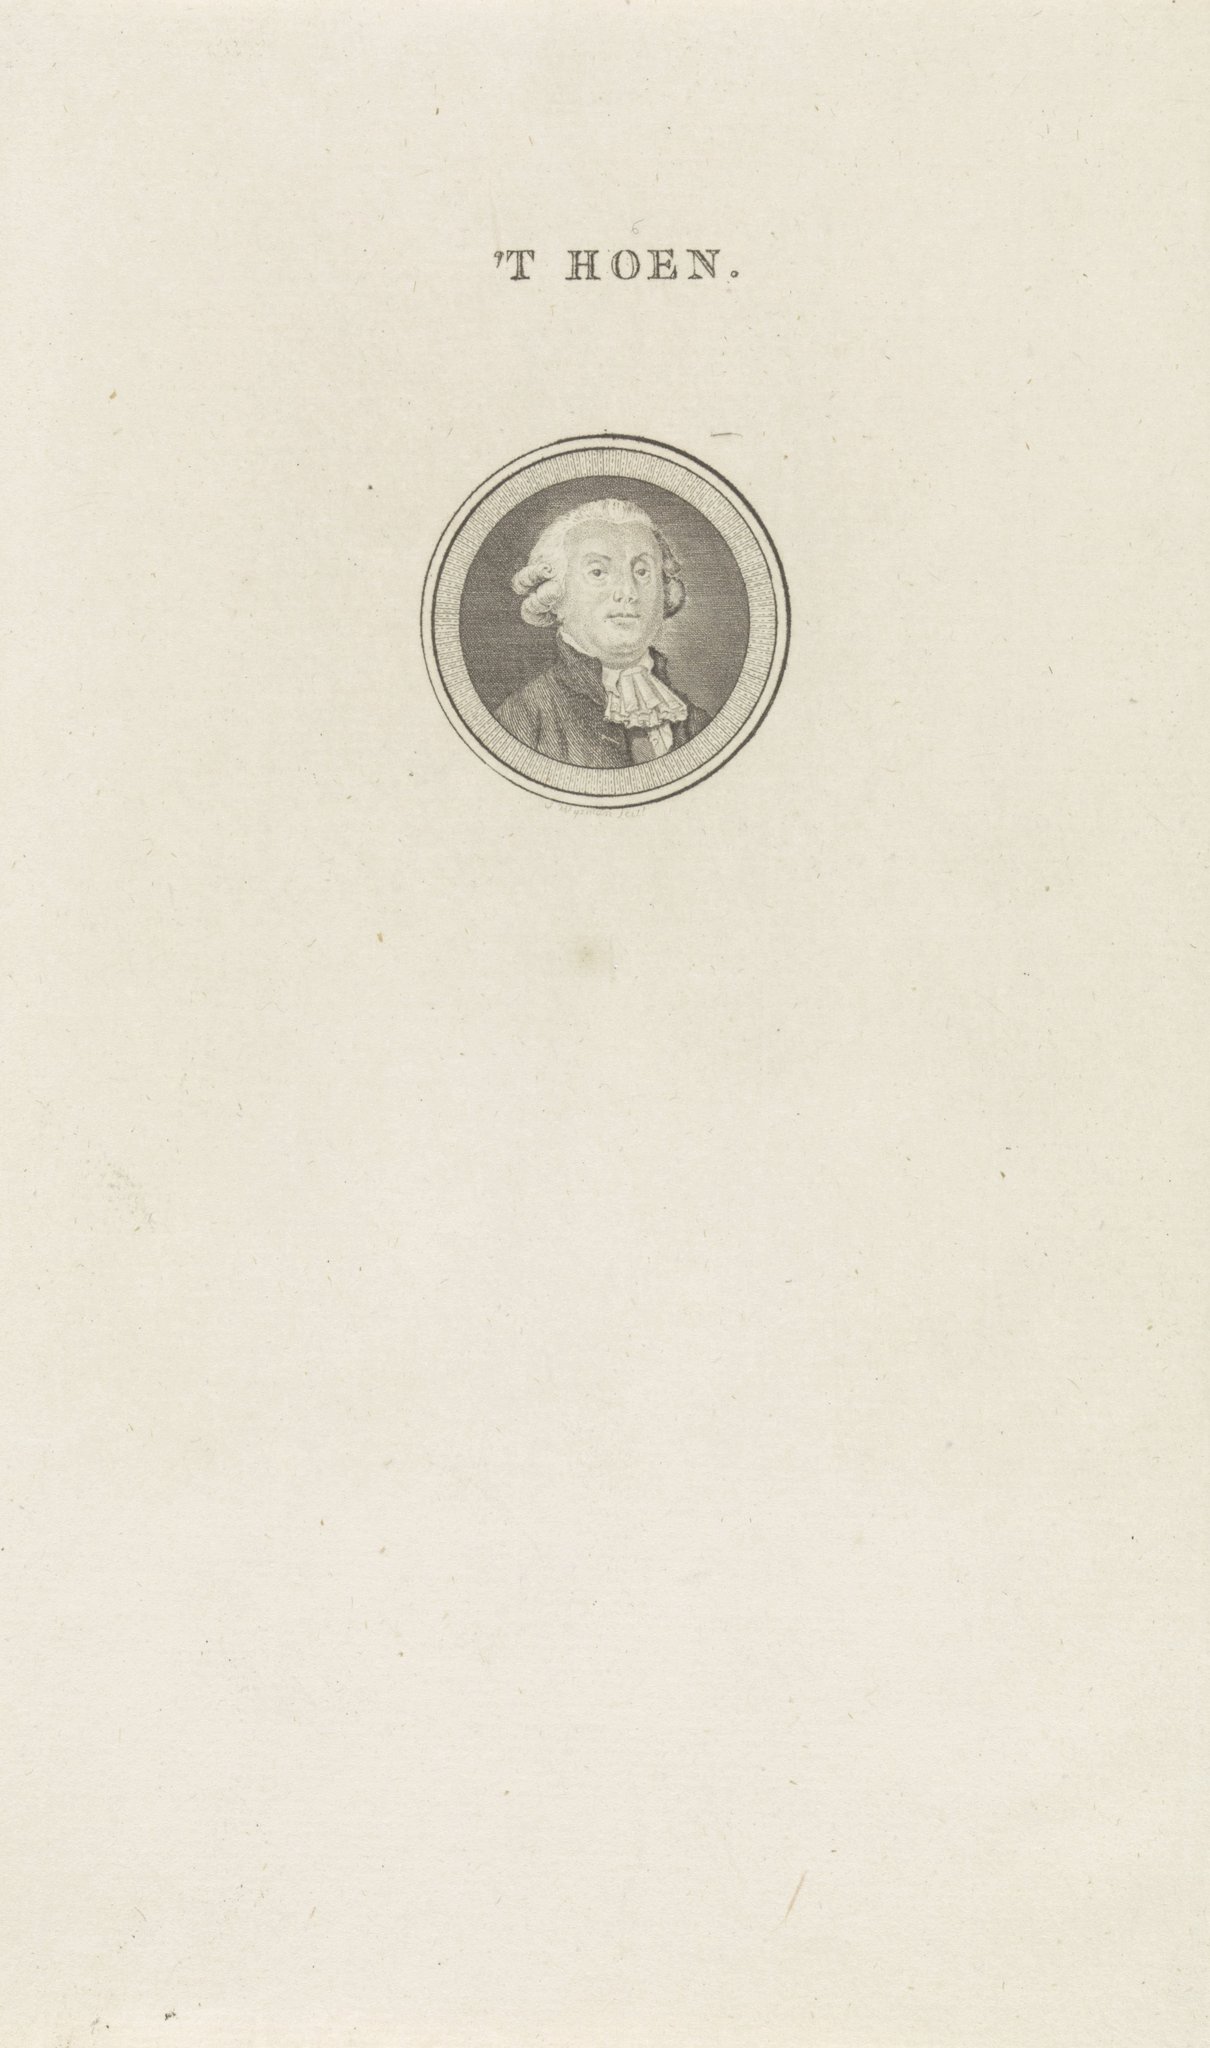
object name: print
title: Portretten van patriotten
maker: jacobus wijsman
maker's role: print maker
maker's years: 1768-1827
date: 1794-1796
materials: paper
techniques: engraving, etching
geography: amsterdam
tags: pieter 't hoen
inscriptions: collector's mark: Lugt 2228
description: Portret van patriot Pieter 't Hoen in een medaillon.